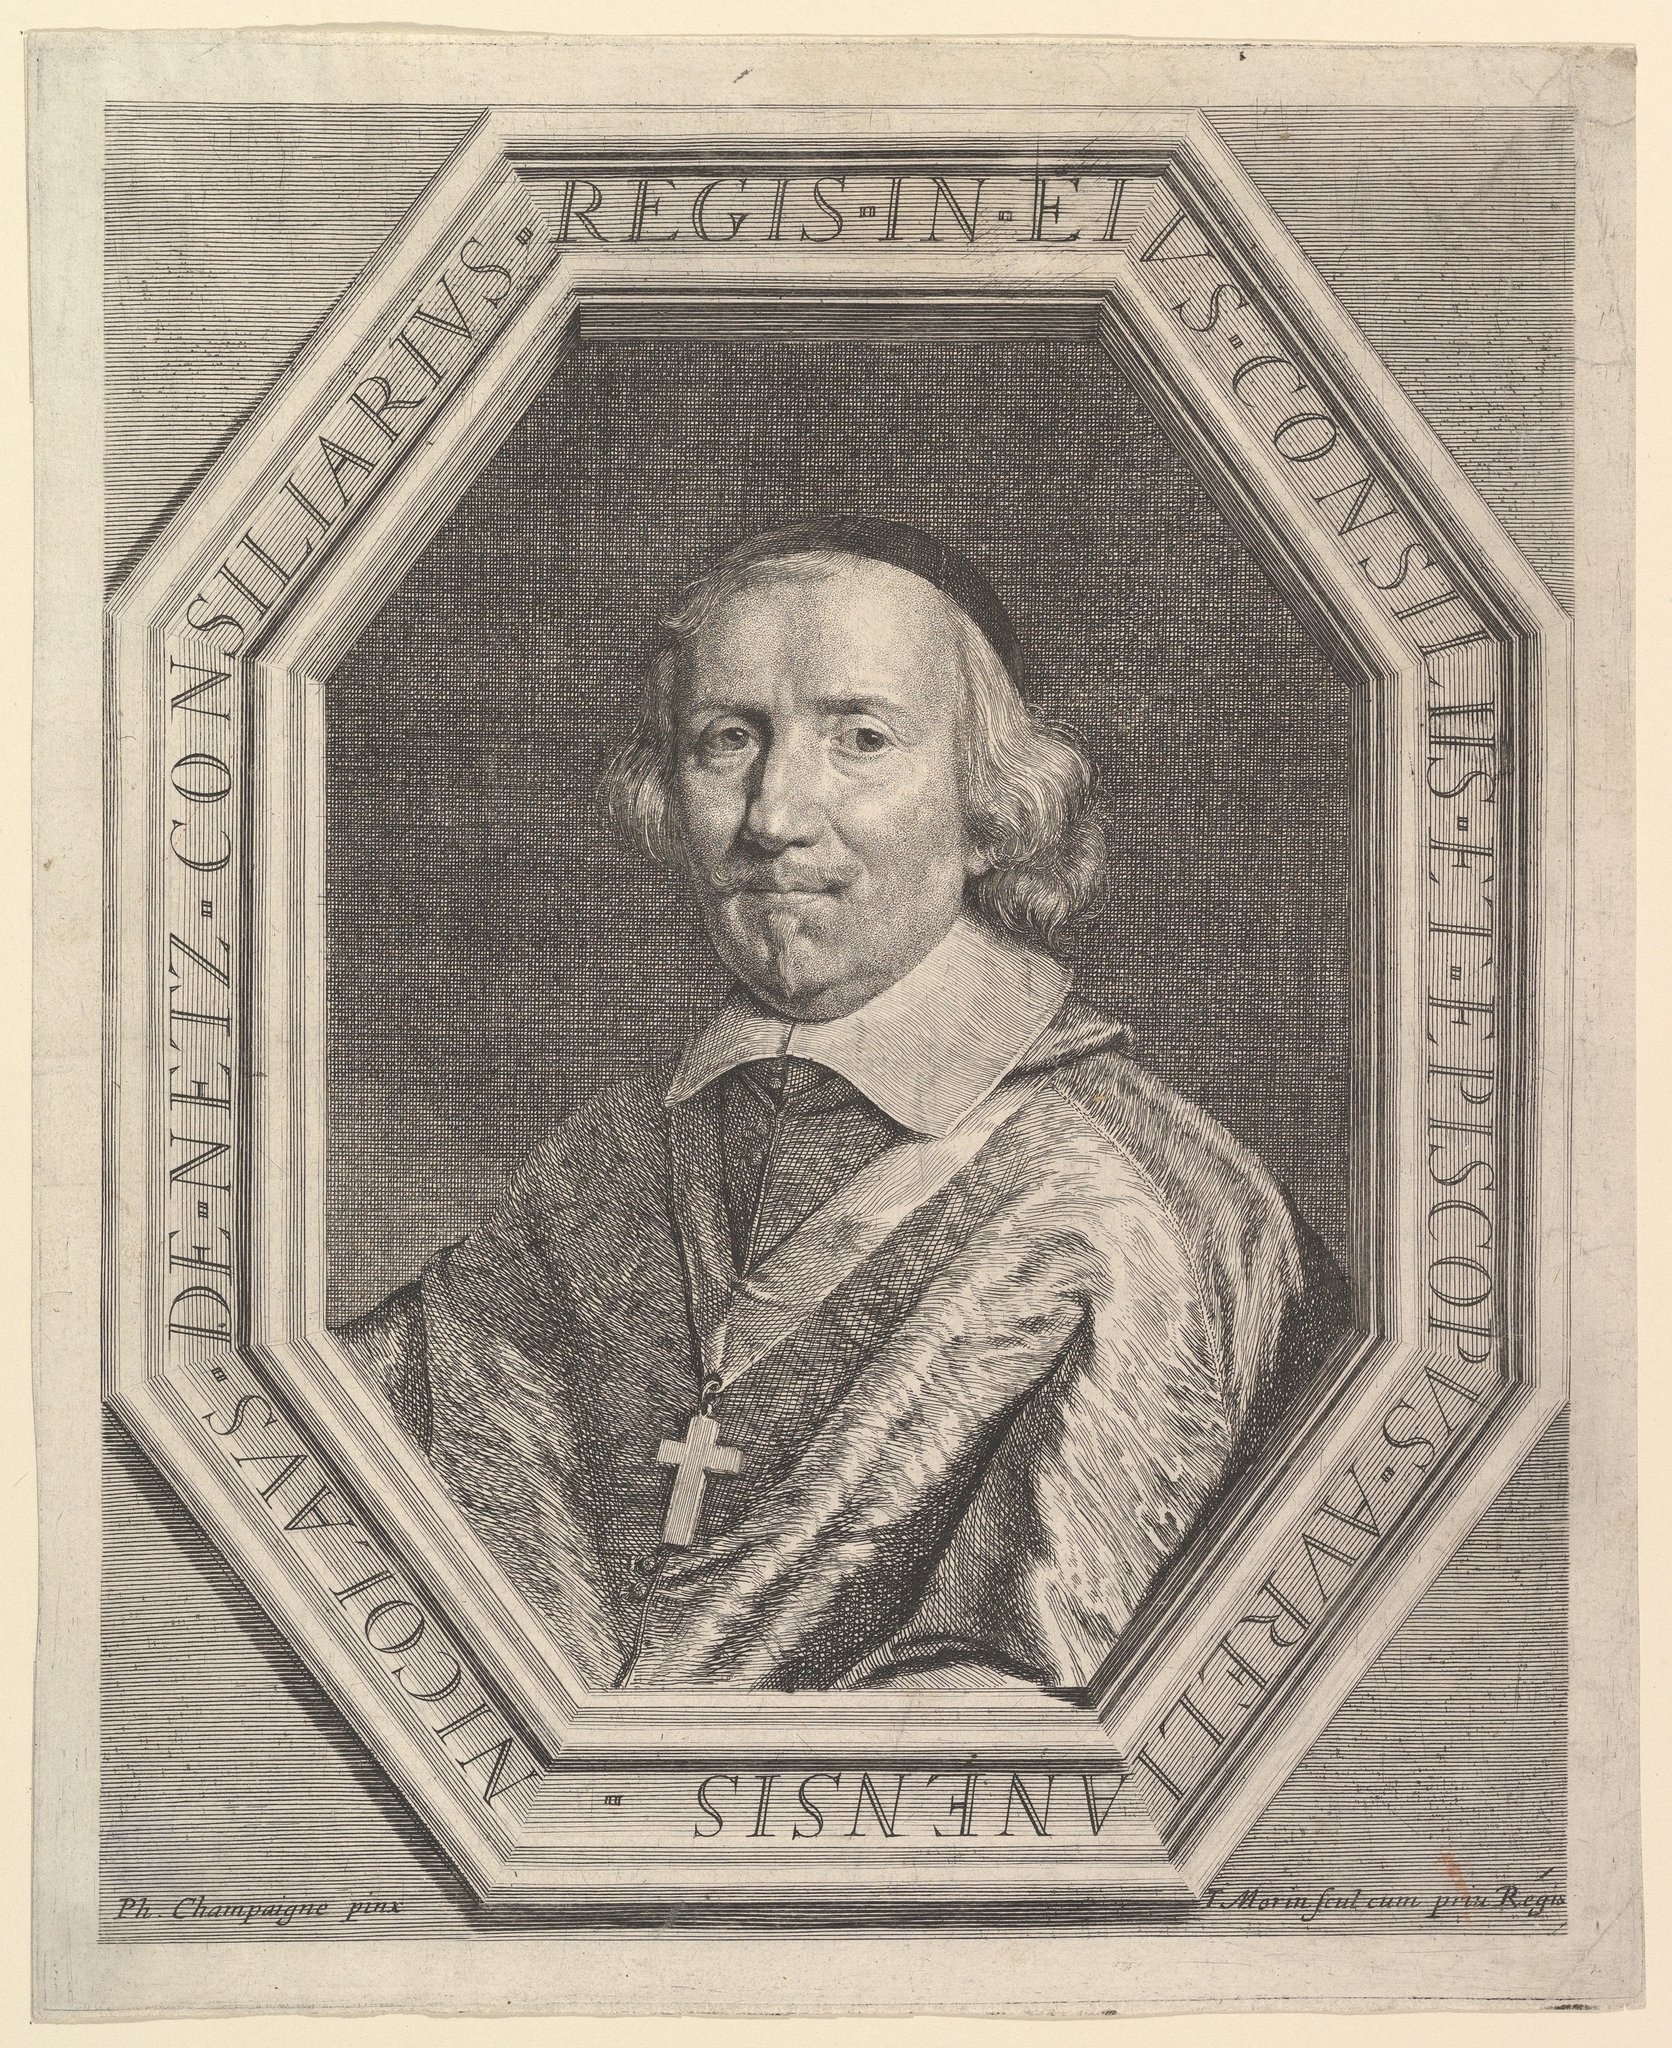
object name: print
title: Nicolas de Netz, eveque d'Orleans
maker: jean morin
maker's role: artist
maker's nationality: french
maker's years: 1605-1650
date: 1605-1650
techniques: etching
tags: men,portraits,cross